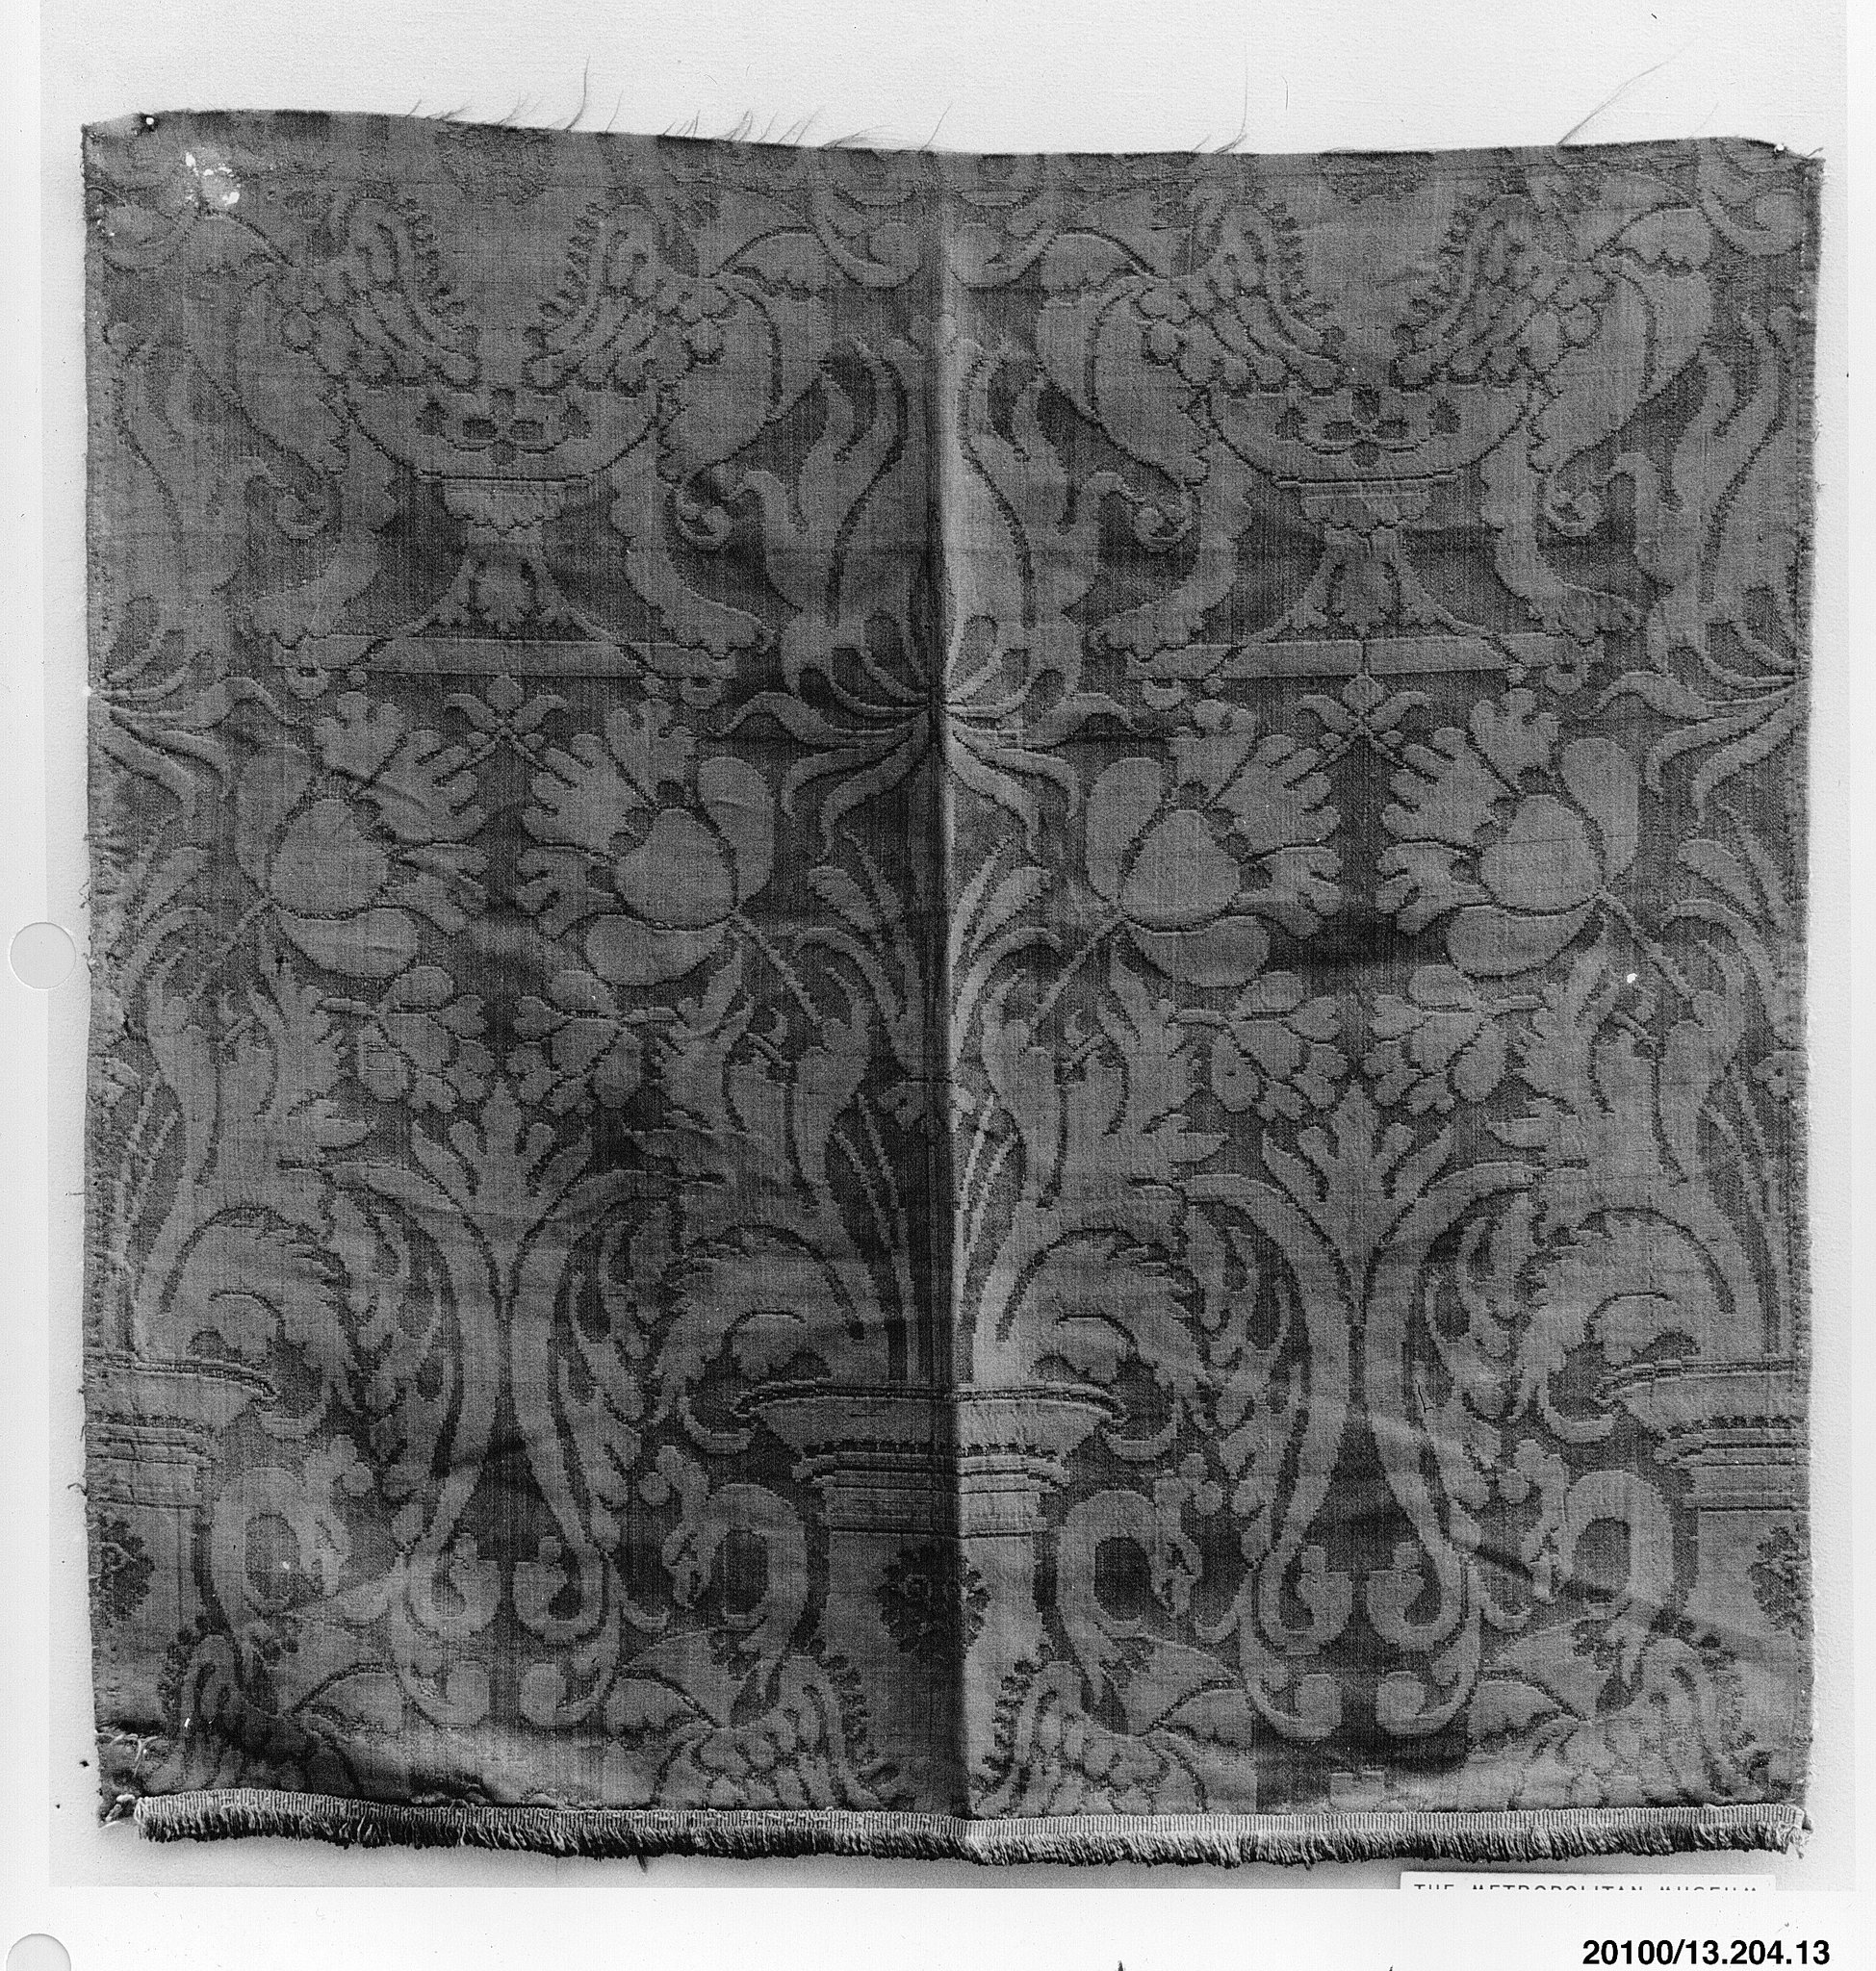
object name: piece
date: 1601-1700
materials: silk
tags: flowers,leaves